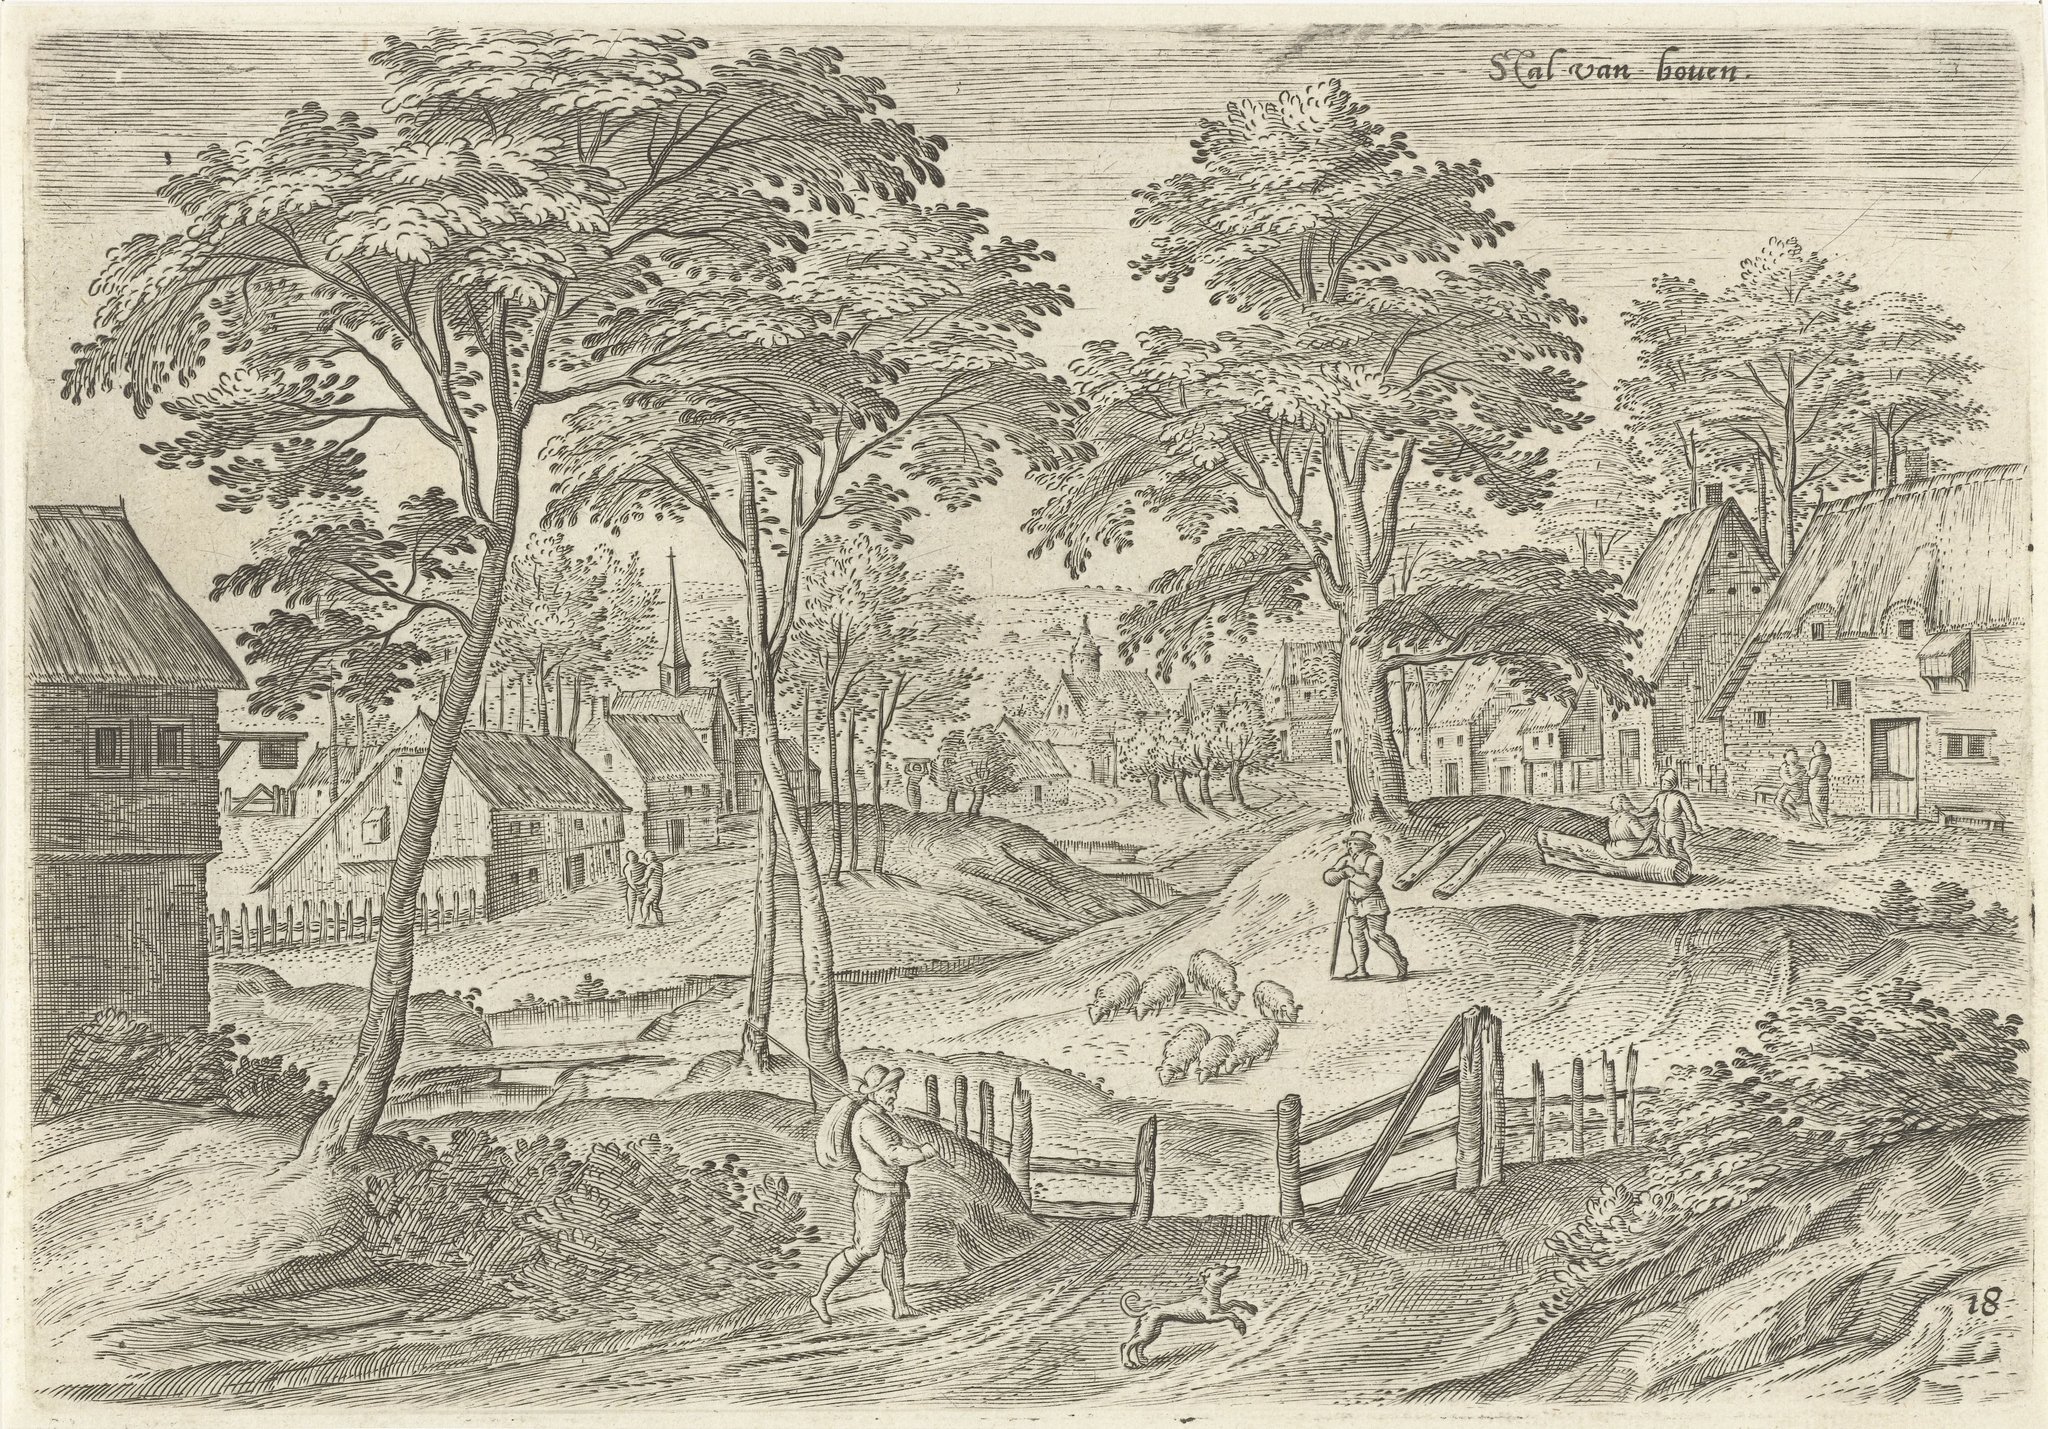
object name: print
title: Gezichten uit de omgeving van Brussel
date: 1530-1580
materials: paper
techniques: engraving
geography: antwerp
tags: village (+ city(-scape) with figures, staffage), brussels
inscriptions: collector's mark: Lugt 2228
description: Gezicht op het dorp Stal, vlakbij Brussel. De prent is deel van een serie met gezichten uit de omgeving van Brussel.